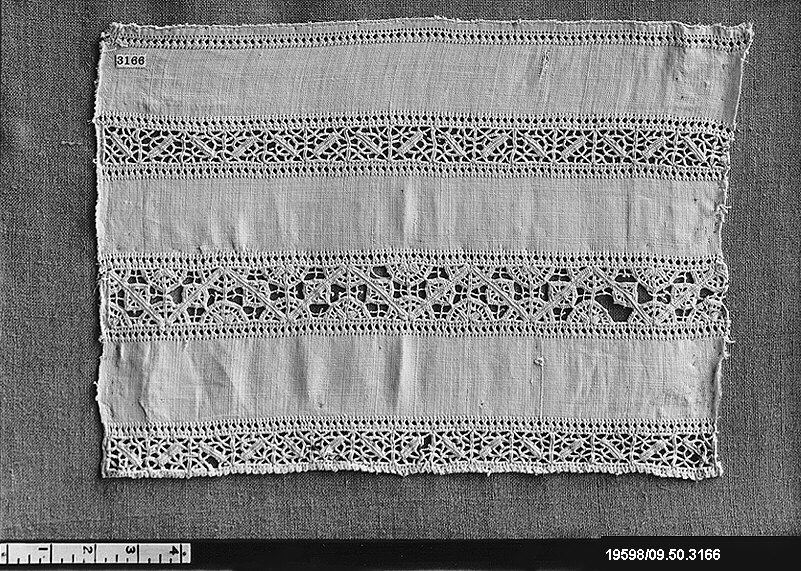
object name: fragment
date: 1601-1700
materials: linen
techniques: embroidery